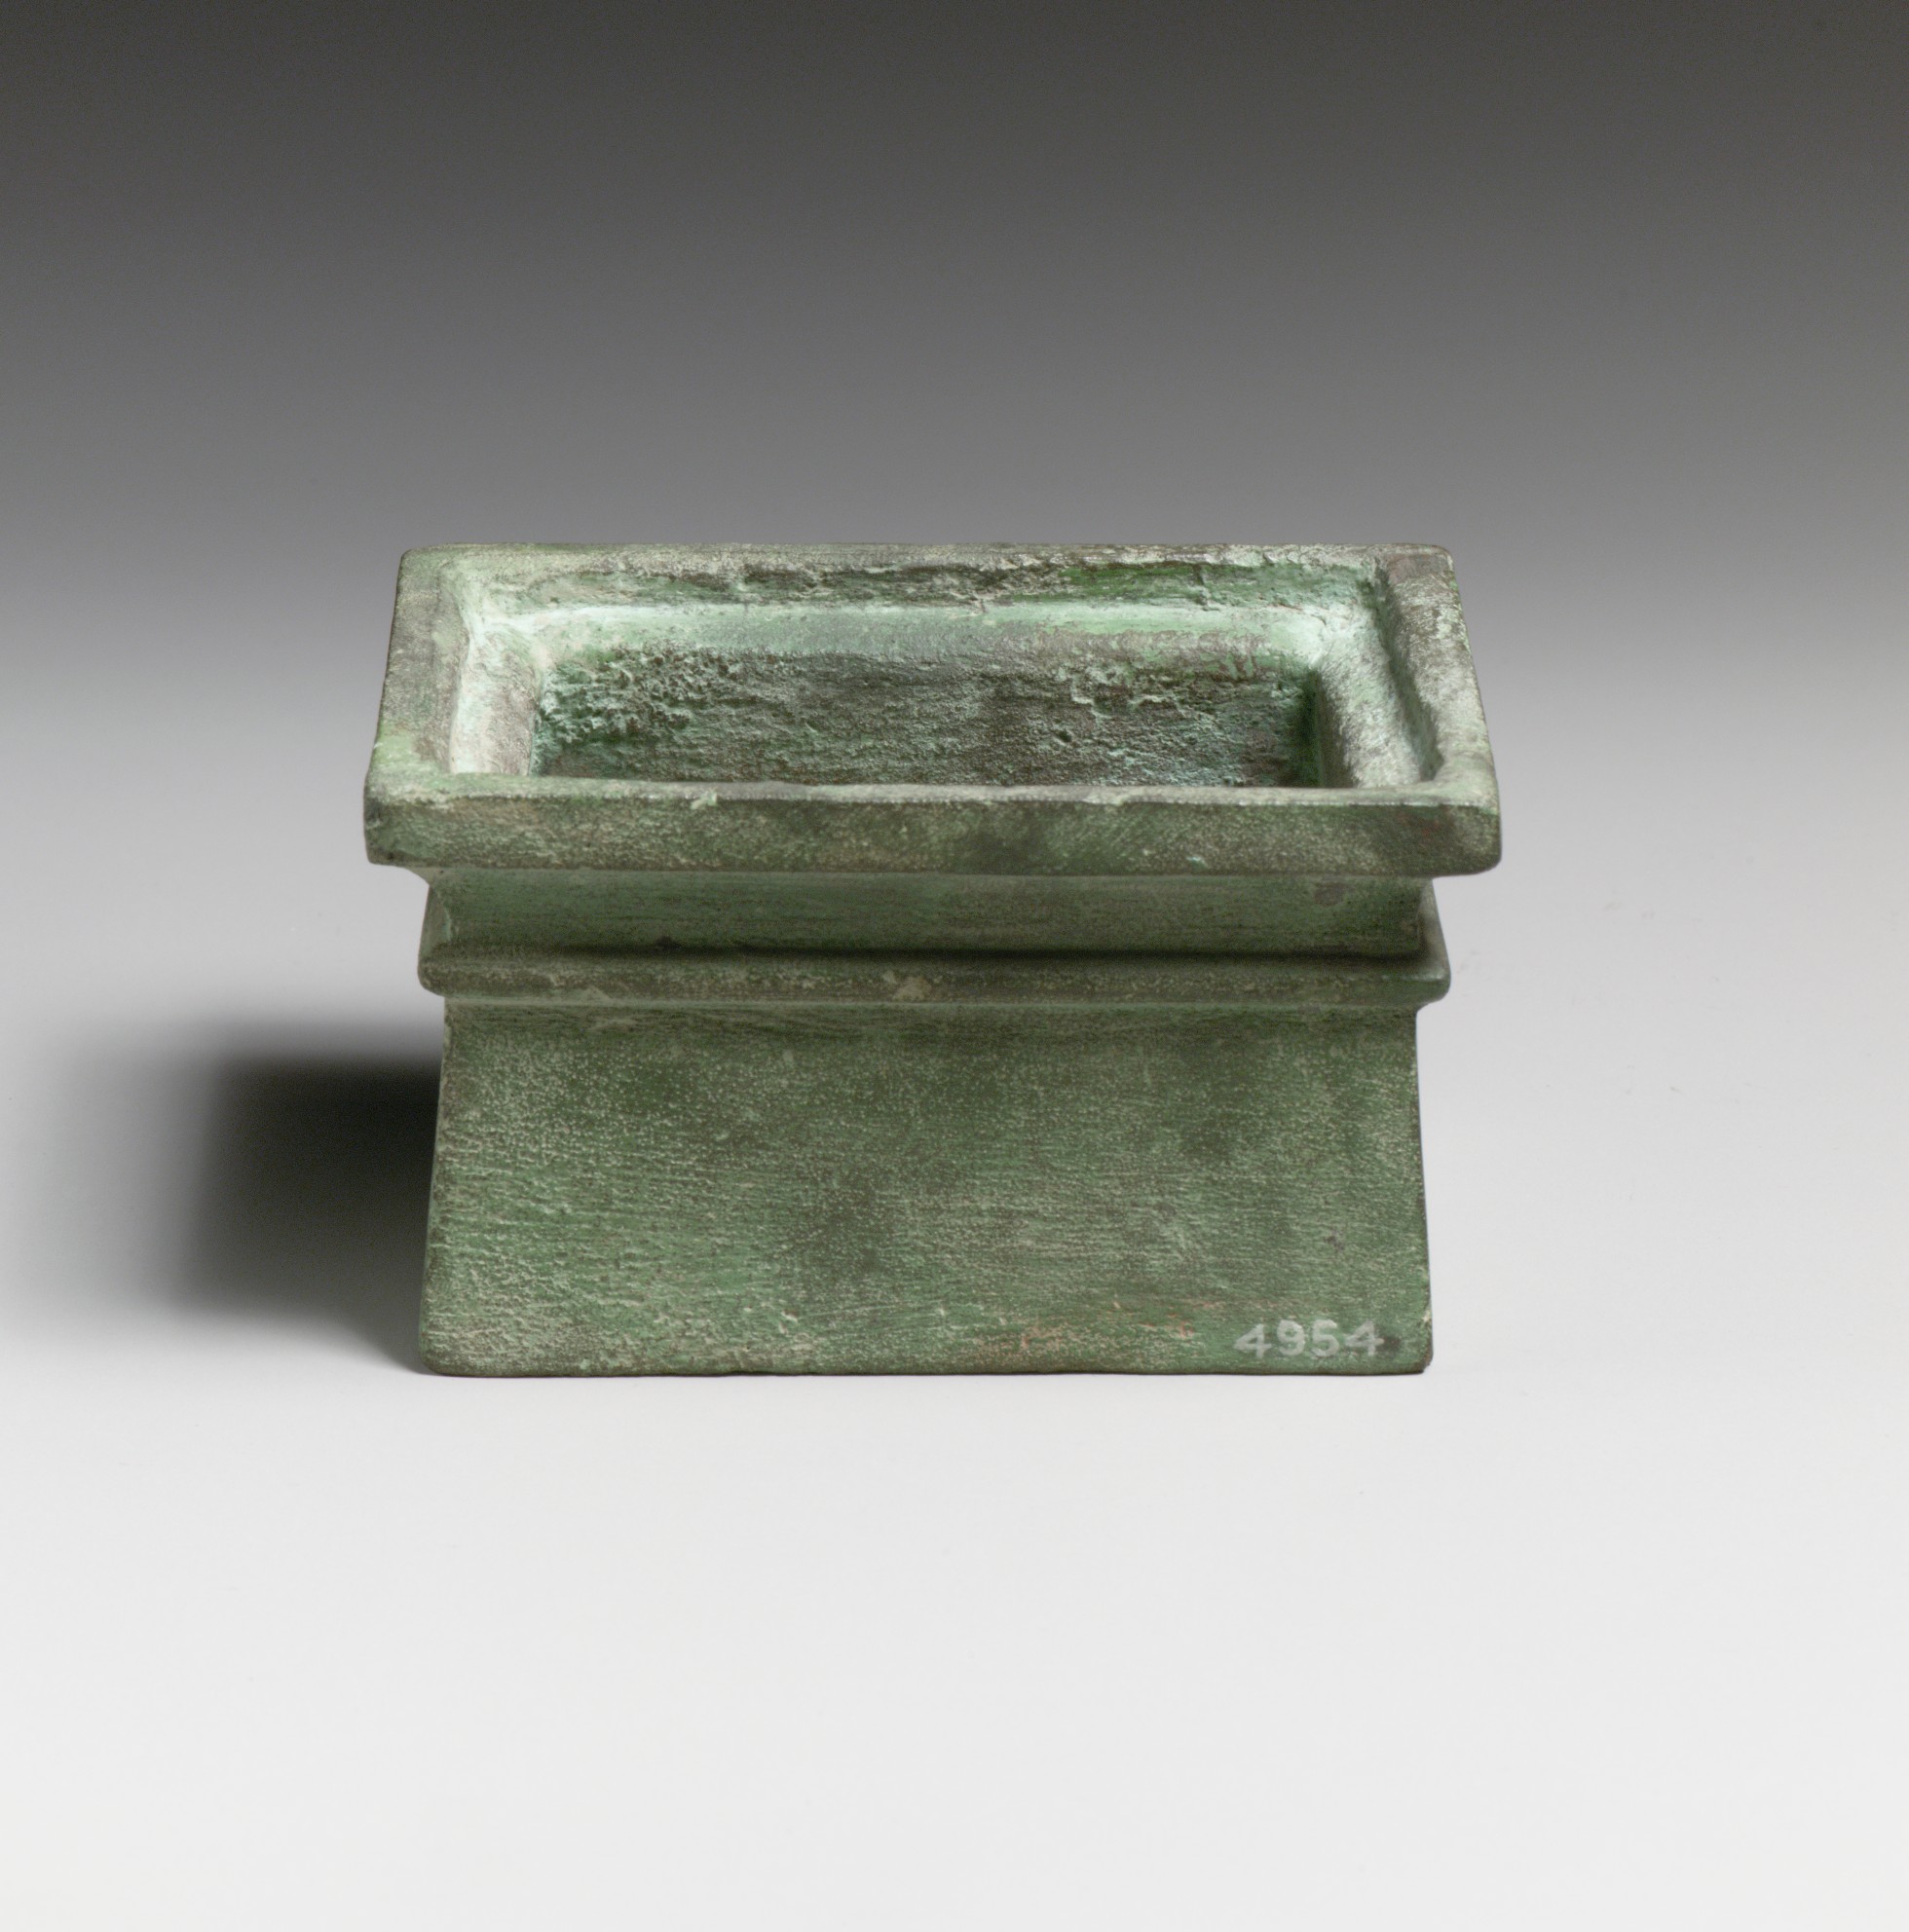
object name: box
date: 7000 BCE-330 CE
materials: bronze